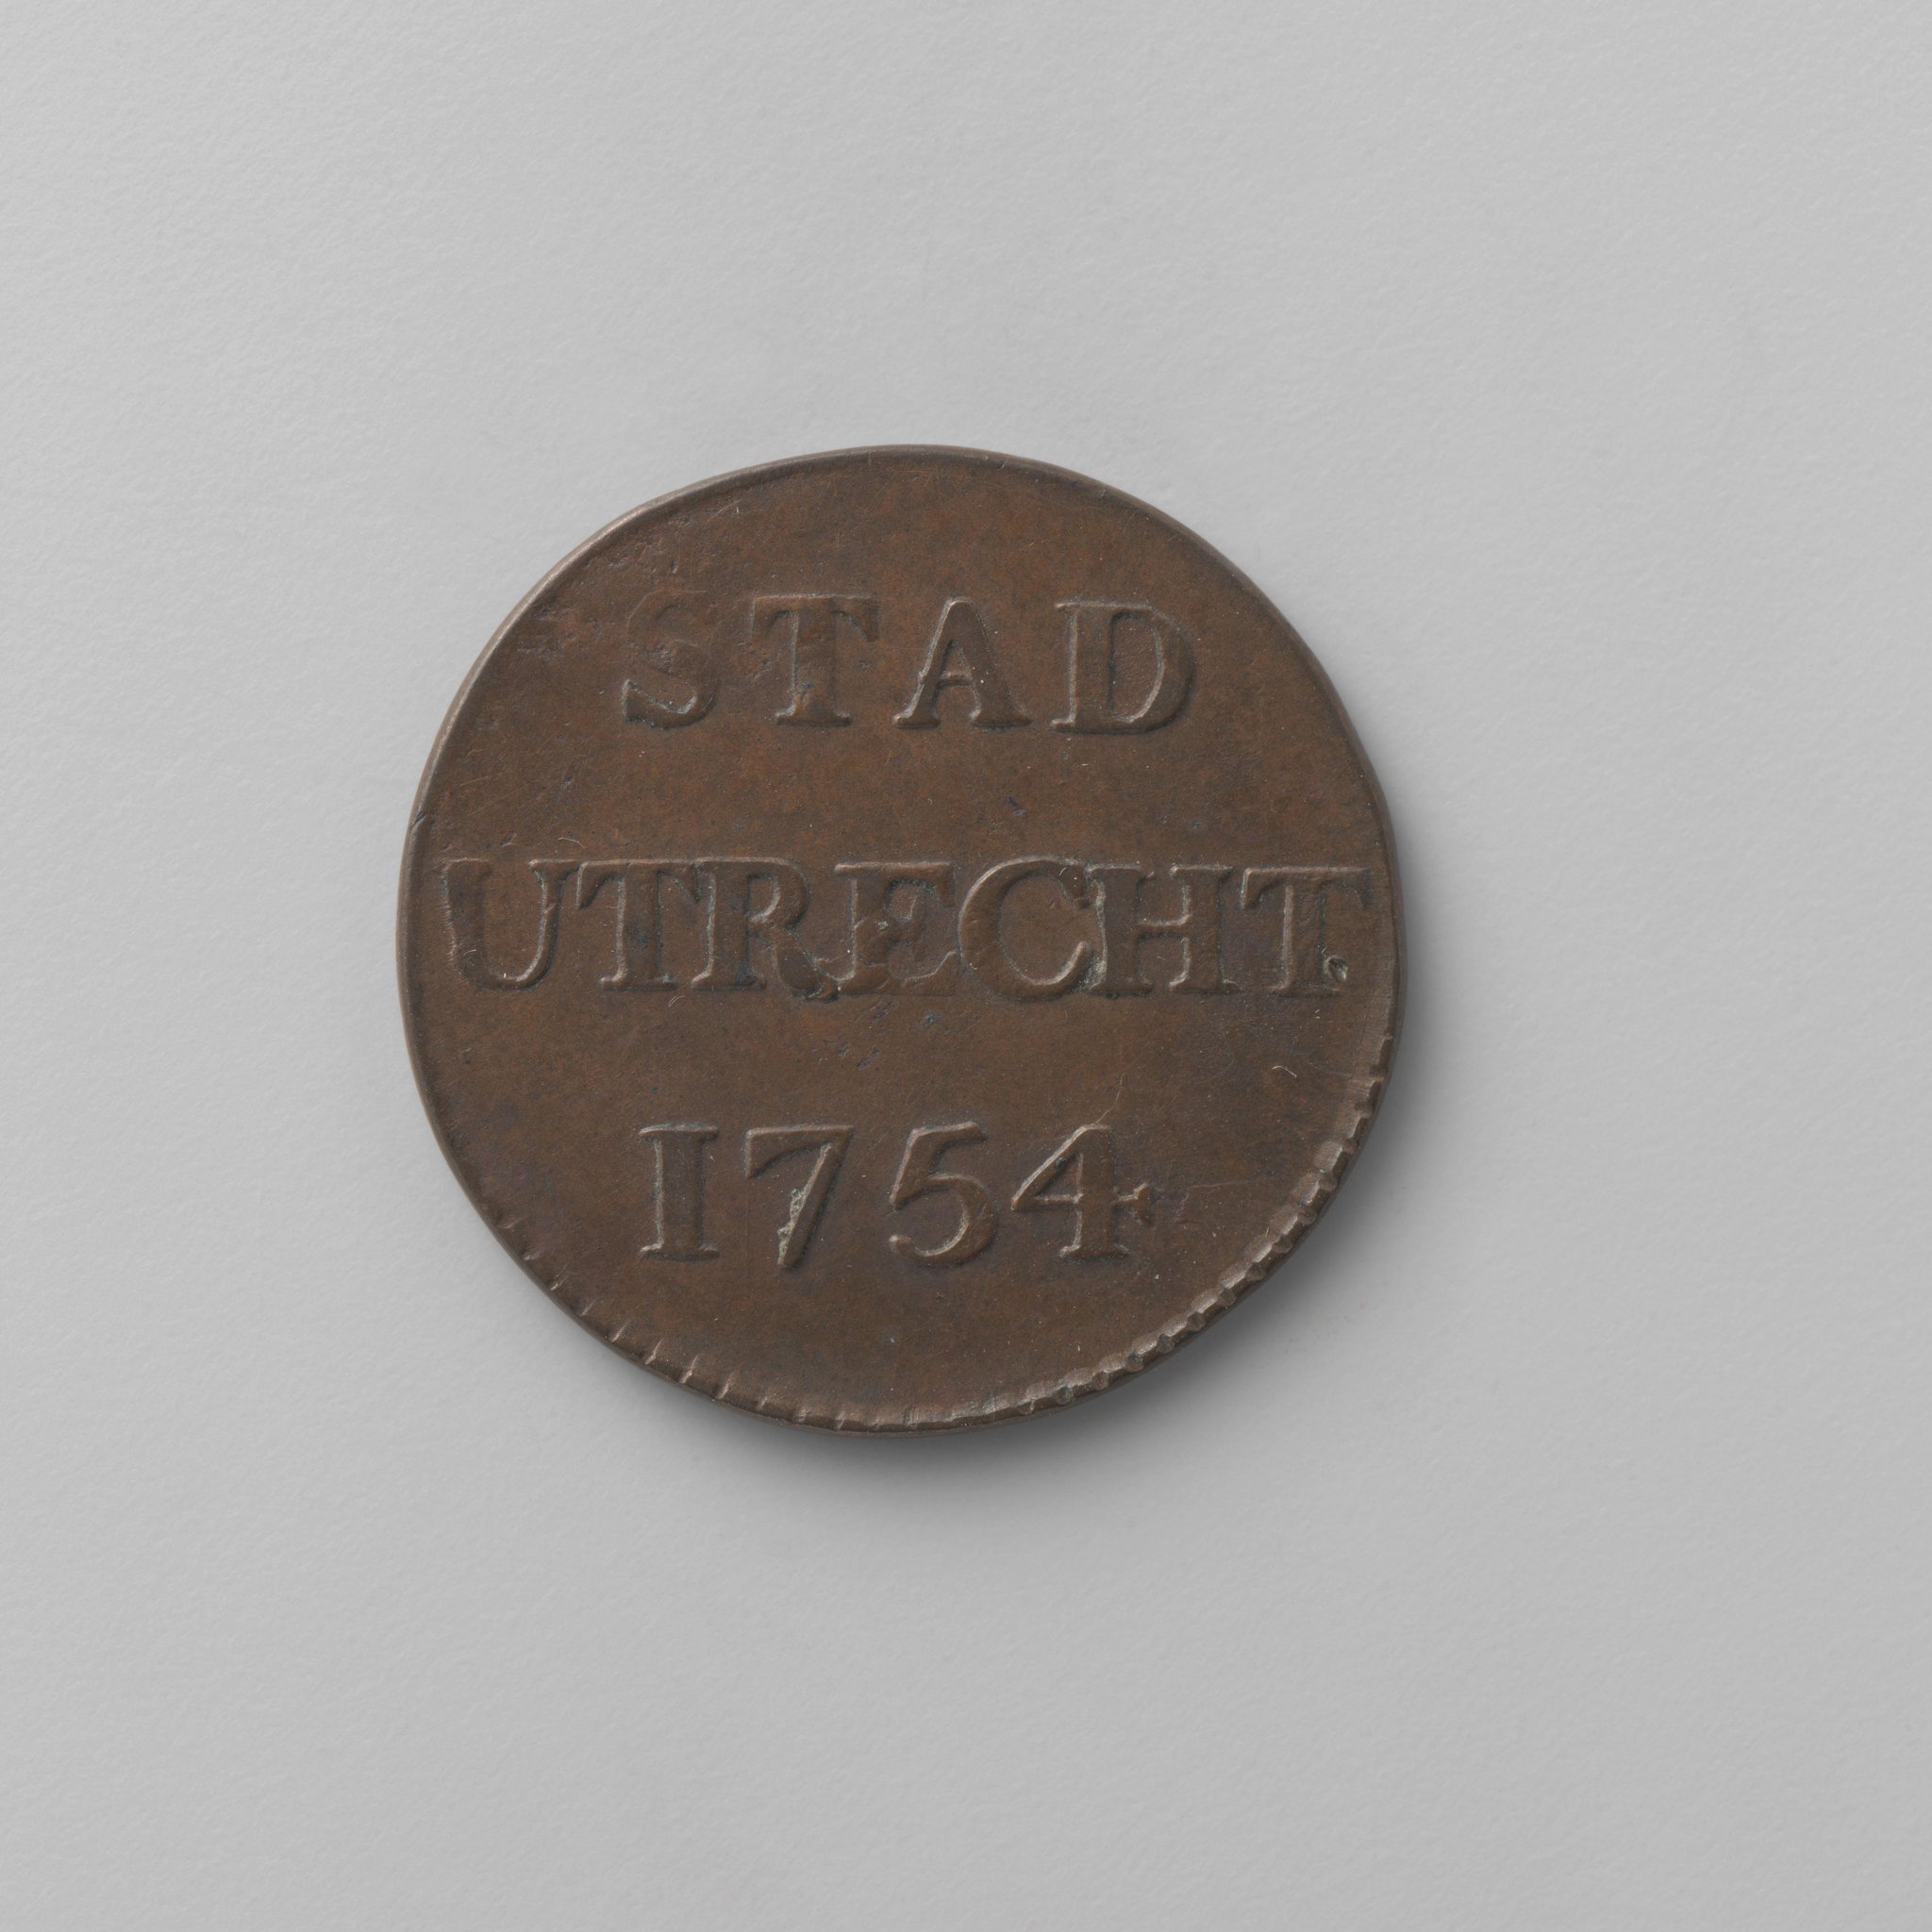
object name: coin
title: Duit van de stad Utrecht, 1754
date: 1754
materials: copper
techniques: striking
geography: utrecht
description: Koperen munt. Voorzijde: gekroond stedelijk wapenschild, gehouden door twee leeuwen met in afsnede dunne lijn, waaronder een versierde accolade met een grote schelp. Keerzijde: opschrift in twee regels, waaronder jaartal. Jaartal met Romeinse I.